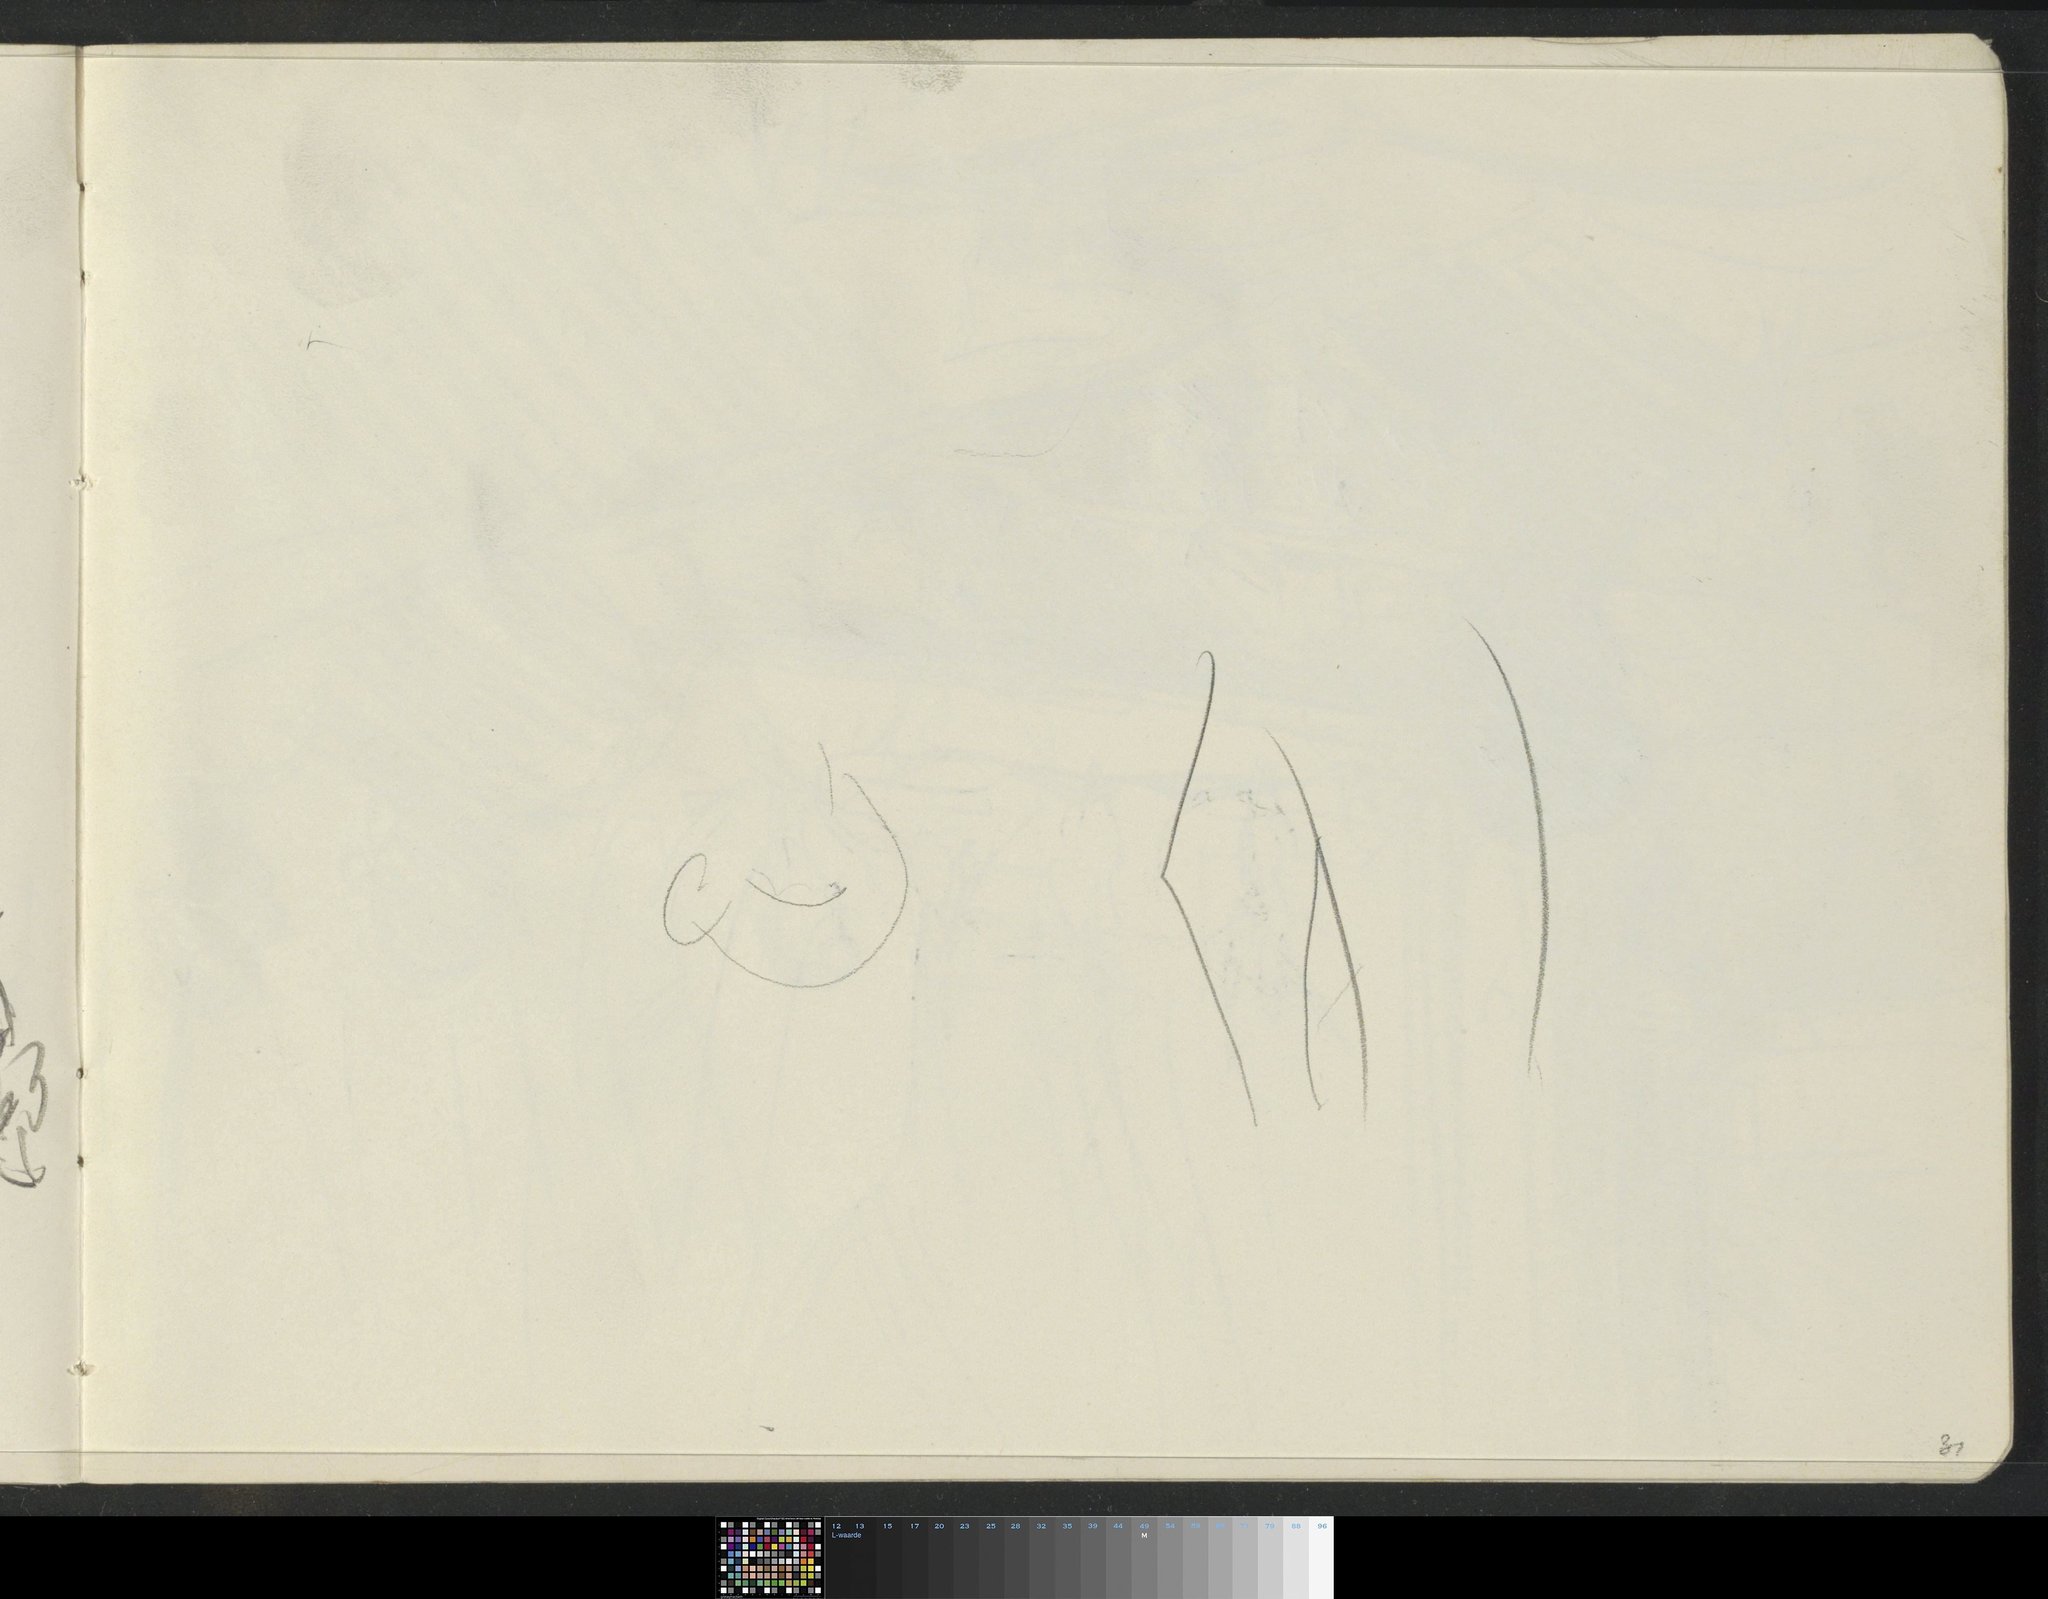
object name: sketchbook leaf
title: Studieblad, mogelijk met een hoofd en benen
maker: isaac israels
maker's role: draughtsman, painter, print maker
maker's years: 1865-1934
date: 1915-1934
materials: paper, pencil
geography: the hague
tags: head (human), legs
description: Blad 31 recto uit schetsboek XVIII met 35 bladen.